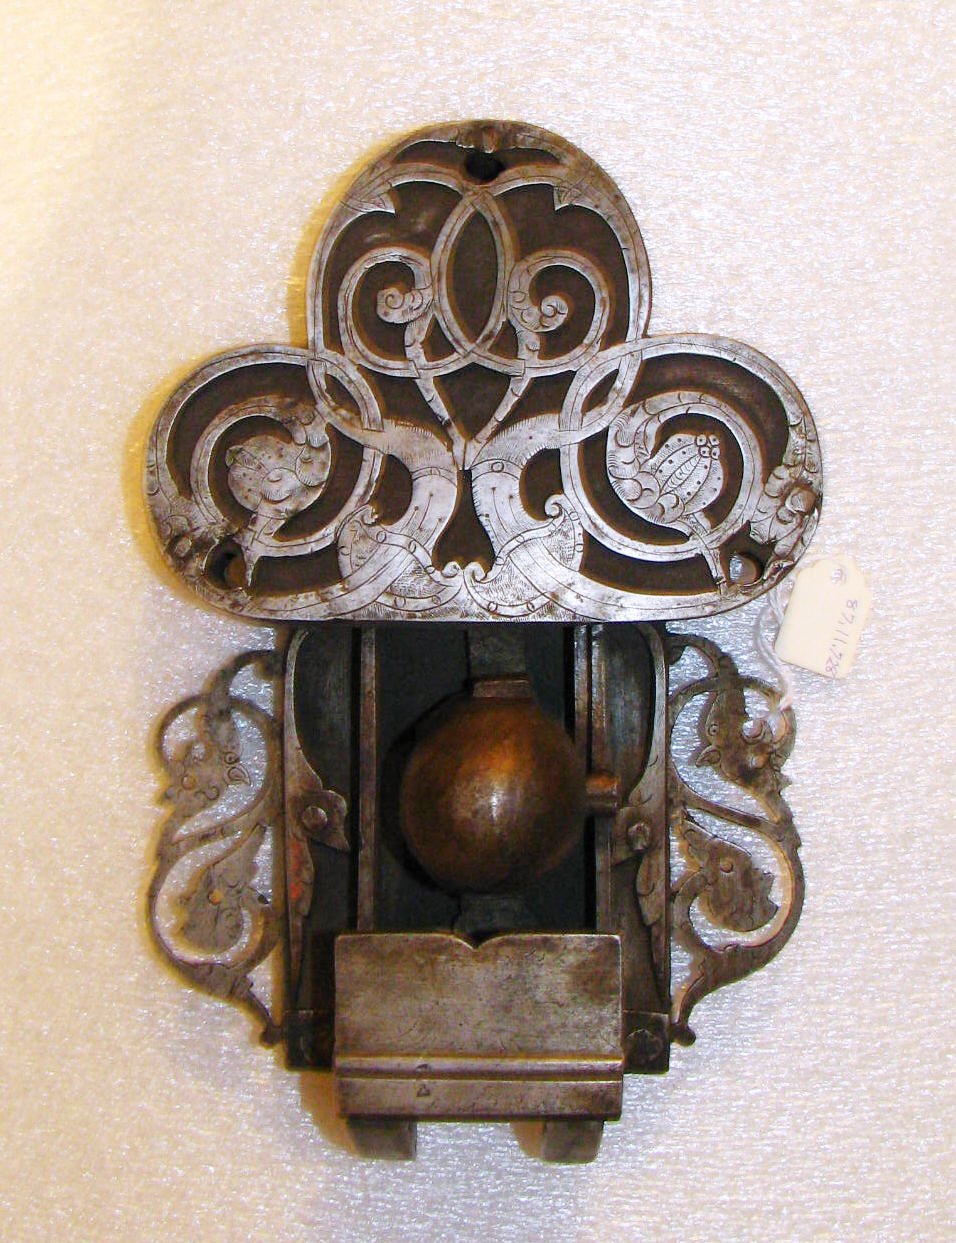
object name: rim lock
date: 1501-1700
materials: iron